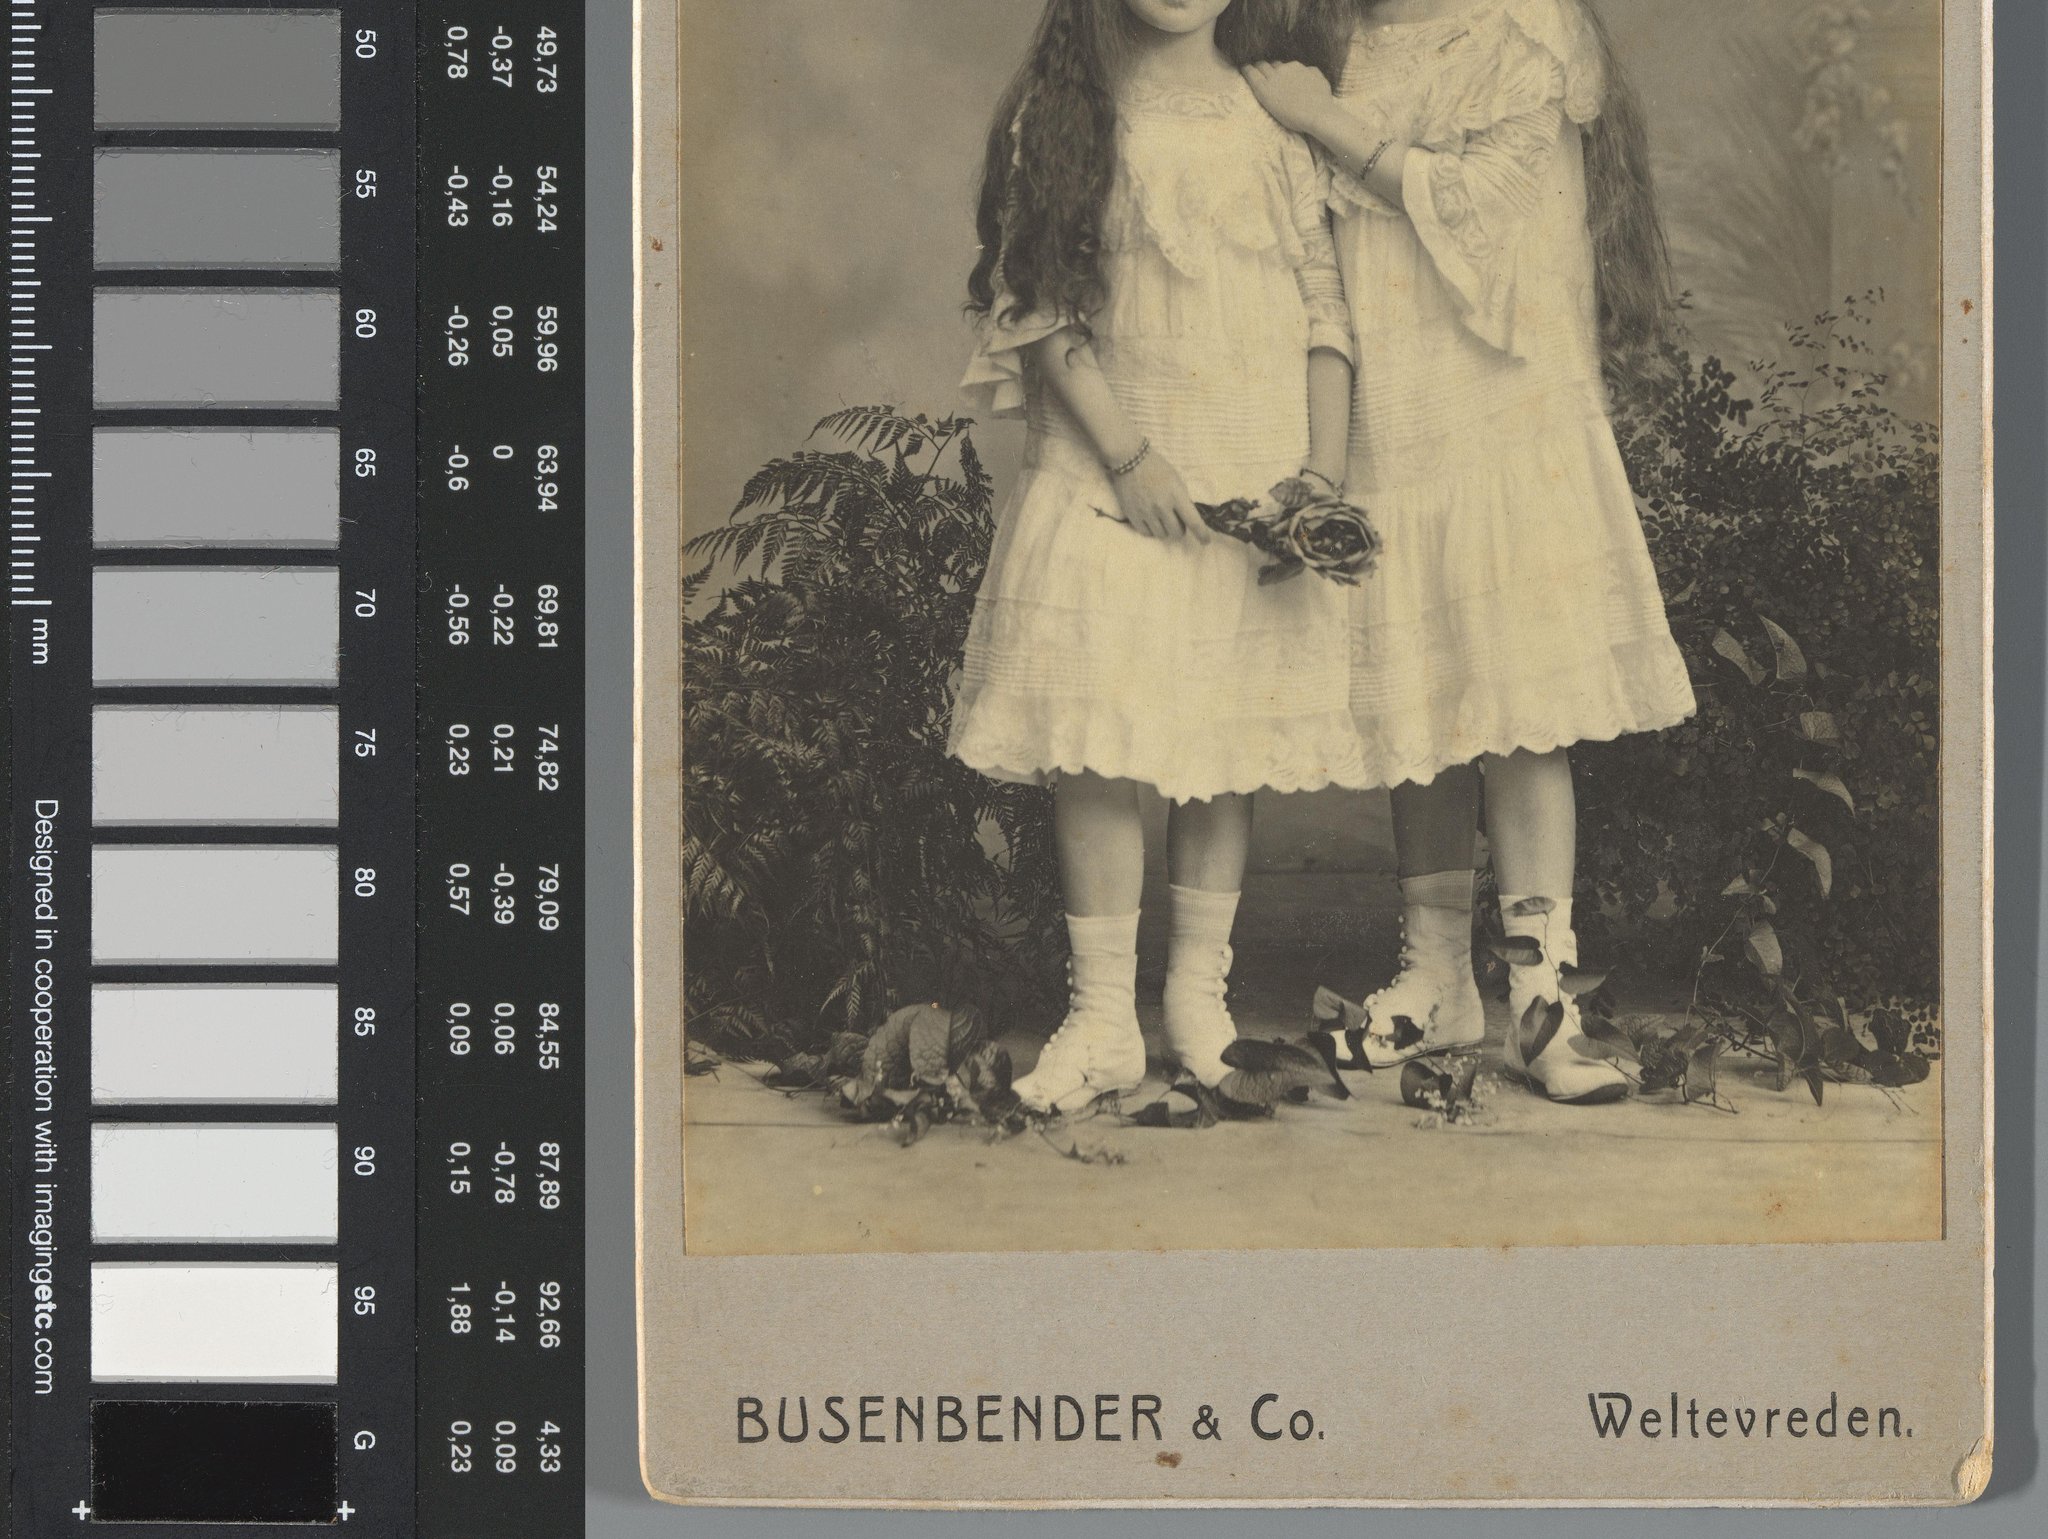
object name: cabinet photograph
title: Studioportret van twee dochters van Emilie van den Berg en Piet Onnen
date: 1900-1910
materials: cardboard, photographic support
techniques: albumen print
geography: batavia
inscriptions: name: ‘BUSENBENDER & Co. / Weltevreden.’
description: Twee meisjes, staand, met elk een strik in het haar tegen een achtergrond met kamerplanten. Het linkermeisje houdt een bloem in aar handen.